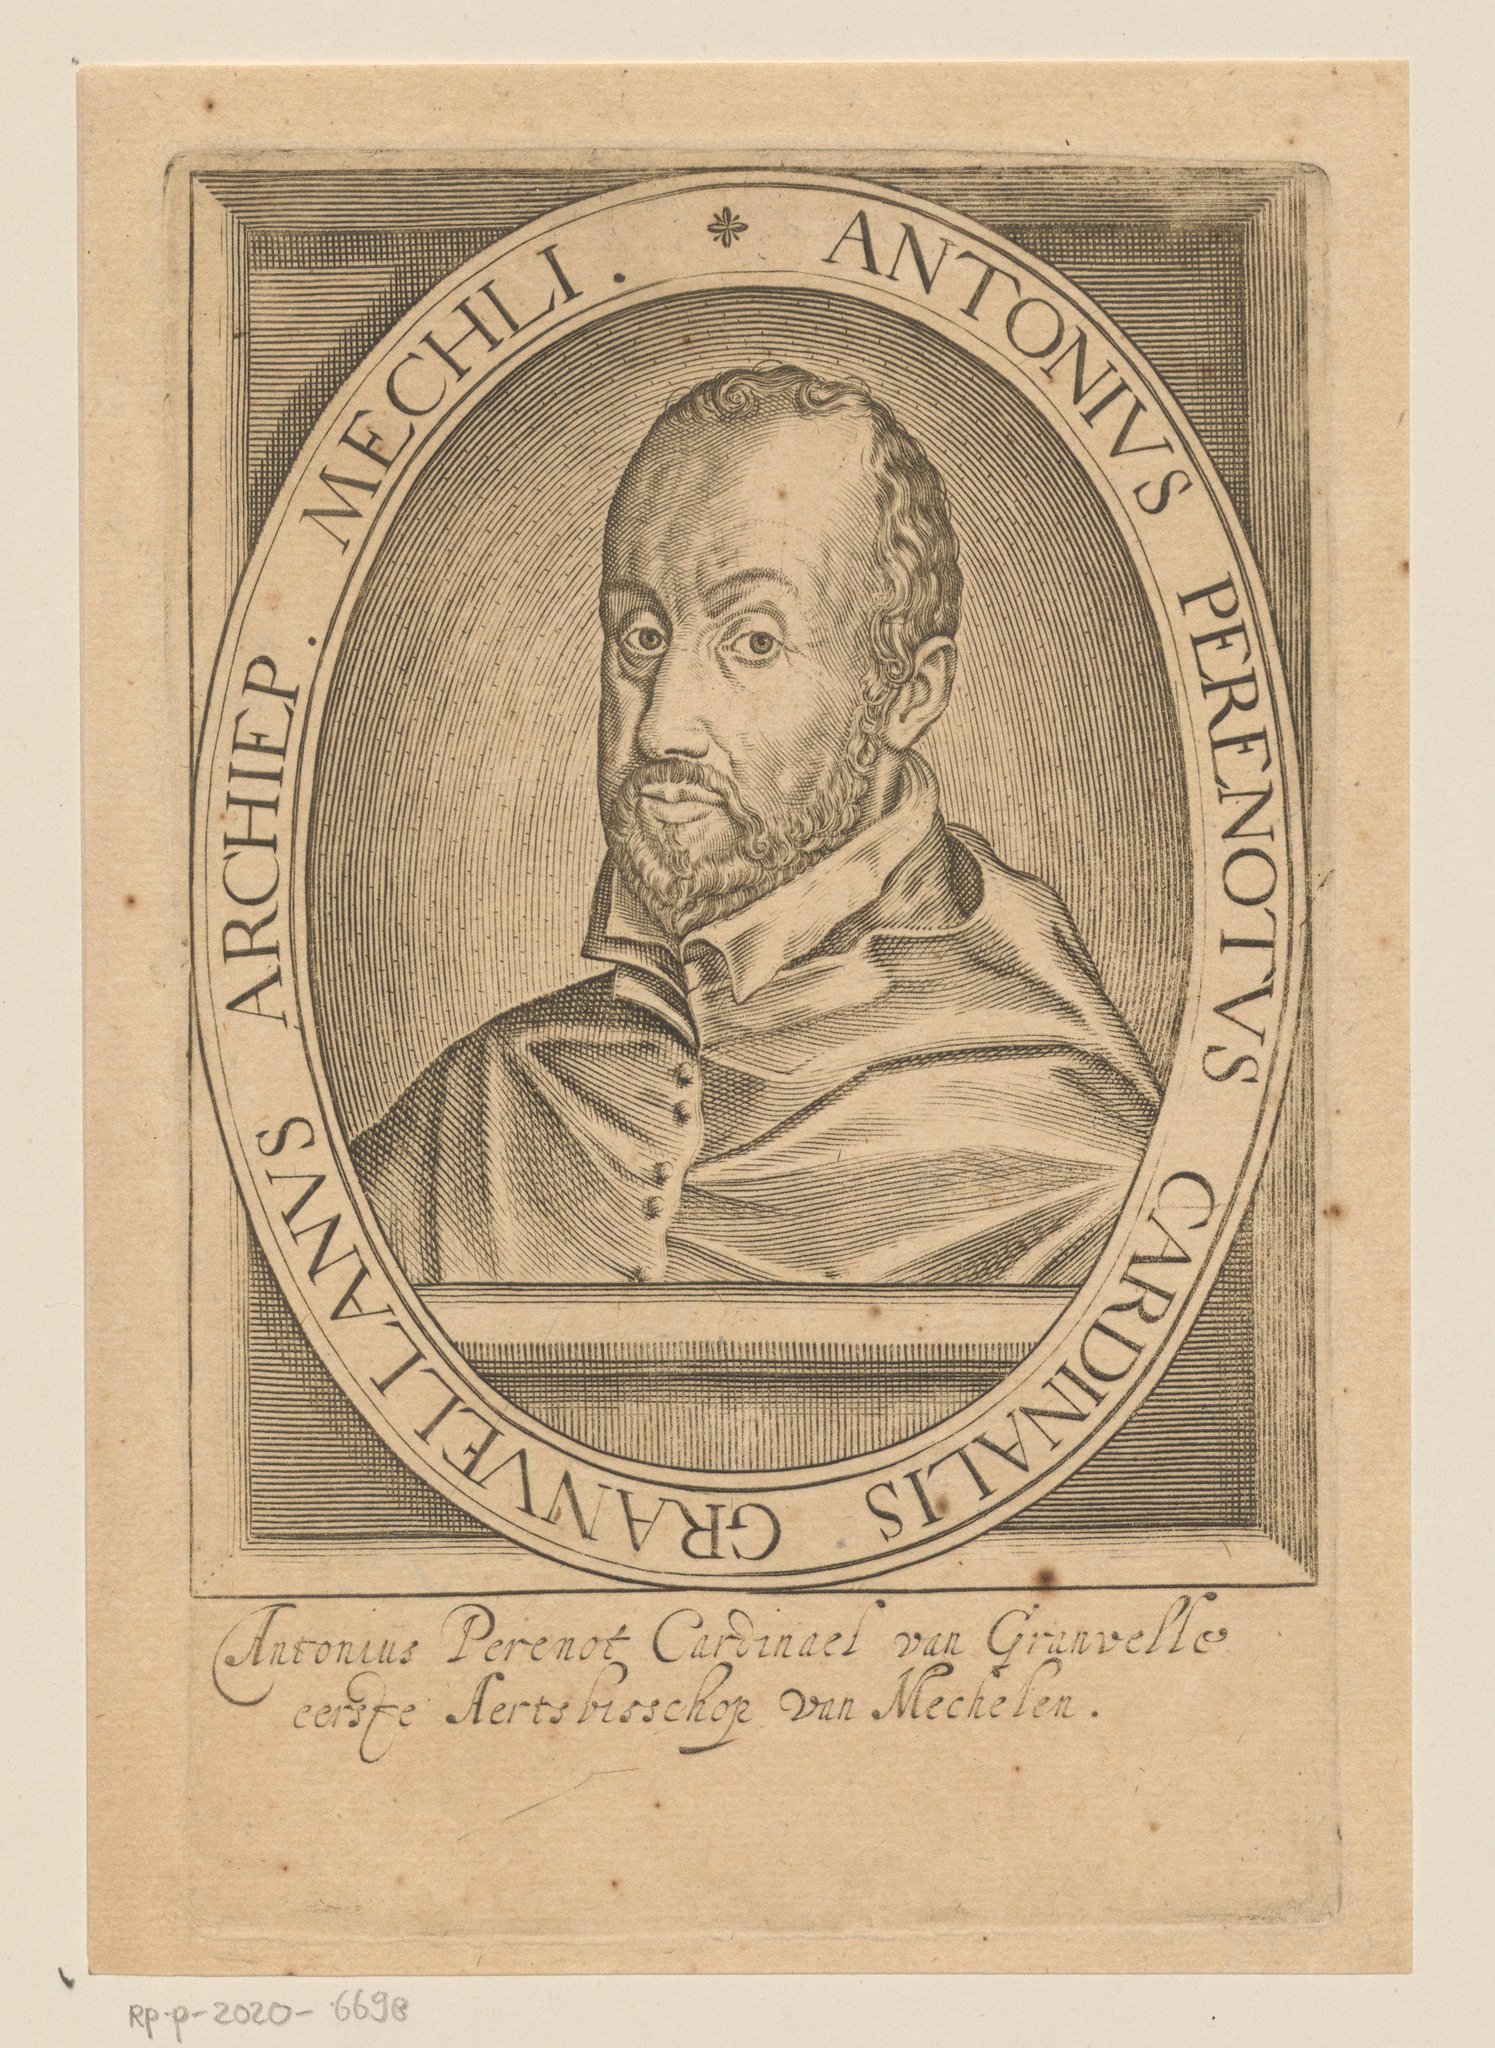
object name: print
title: Portret van Antoine Perrenot de Granvelle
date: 1614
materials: paper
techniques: engraving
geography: the hague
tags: antoine perrenot de granvelle, cardinal, historical persons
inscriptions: number: ‘98’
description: Prent uit: Meteren, Emanuel van. Historie der Nederlandscher ende haerder na-buren oorlogen ende geschiedenissen (...). Den Haag: Hillebrant Iacobsz. van Wouw, 1614. Prent ook gebruikt in: Meteren, Emanuel van. Historie der Nederlandscher ende haerder na-buren oorlogen ende geschiedenissen (...). Den Haag: weduwe en erven Hillebrant Iacobsz. van Wouw, 1623.